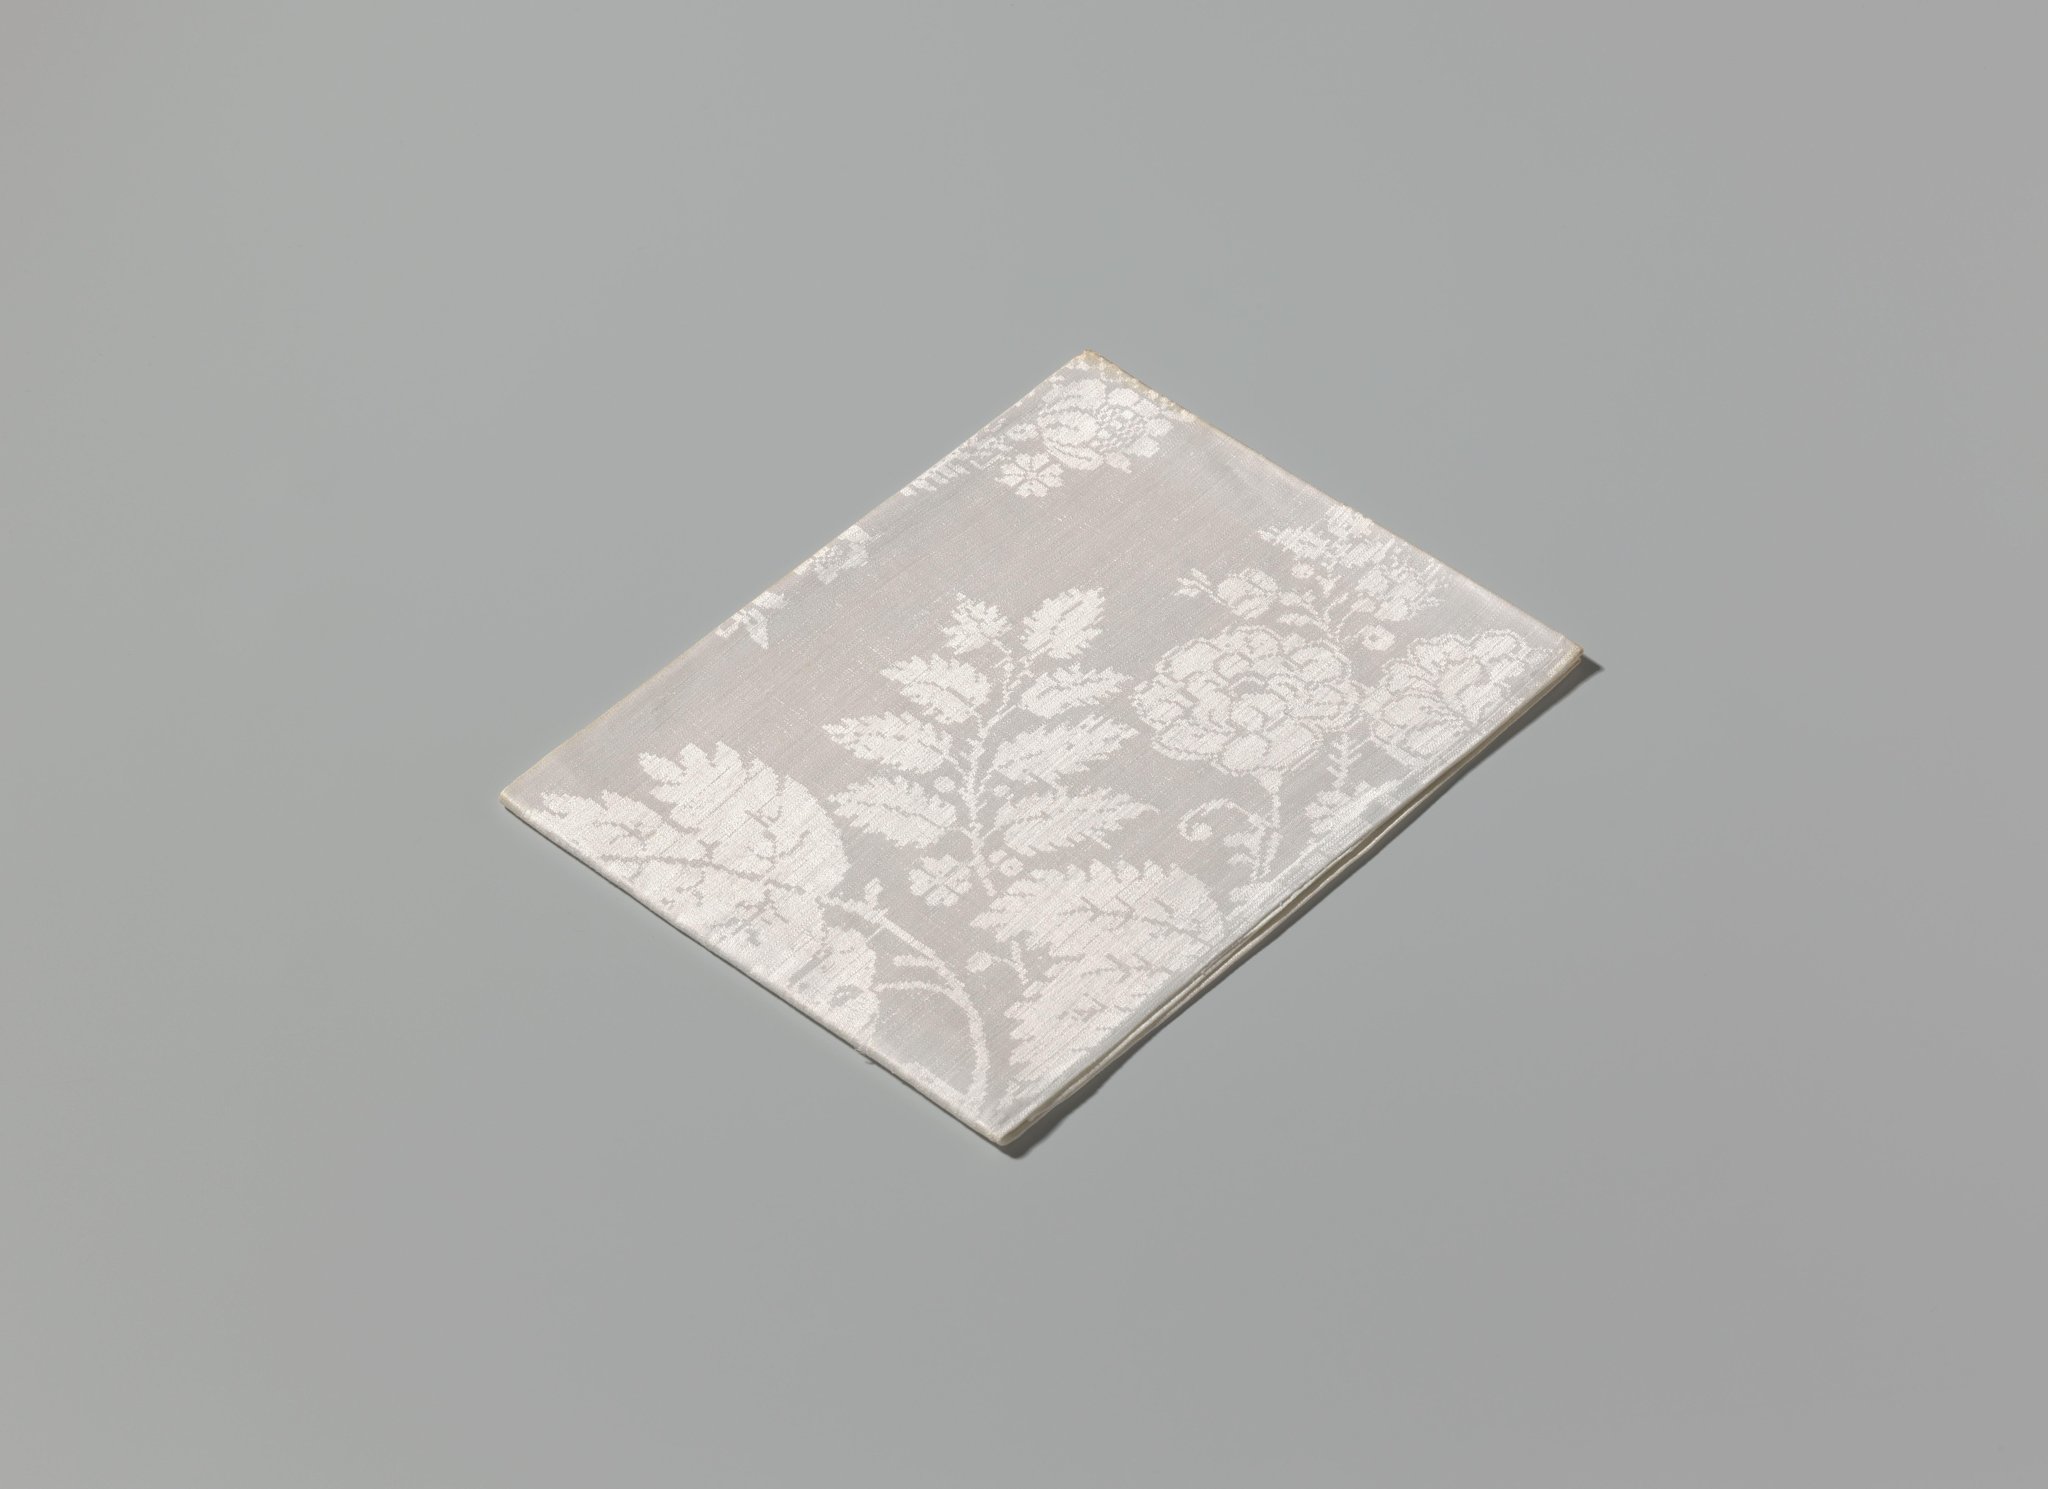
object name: napkin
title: Servet van linnendamast met een kantpatroon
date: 1725-1730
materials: linen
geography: northern netherlands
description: Wit linnendamasten servet met z.g. kantpatroon, merk kroon IAVG 16.